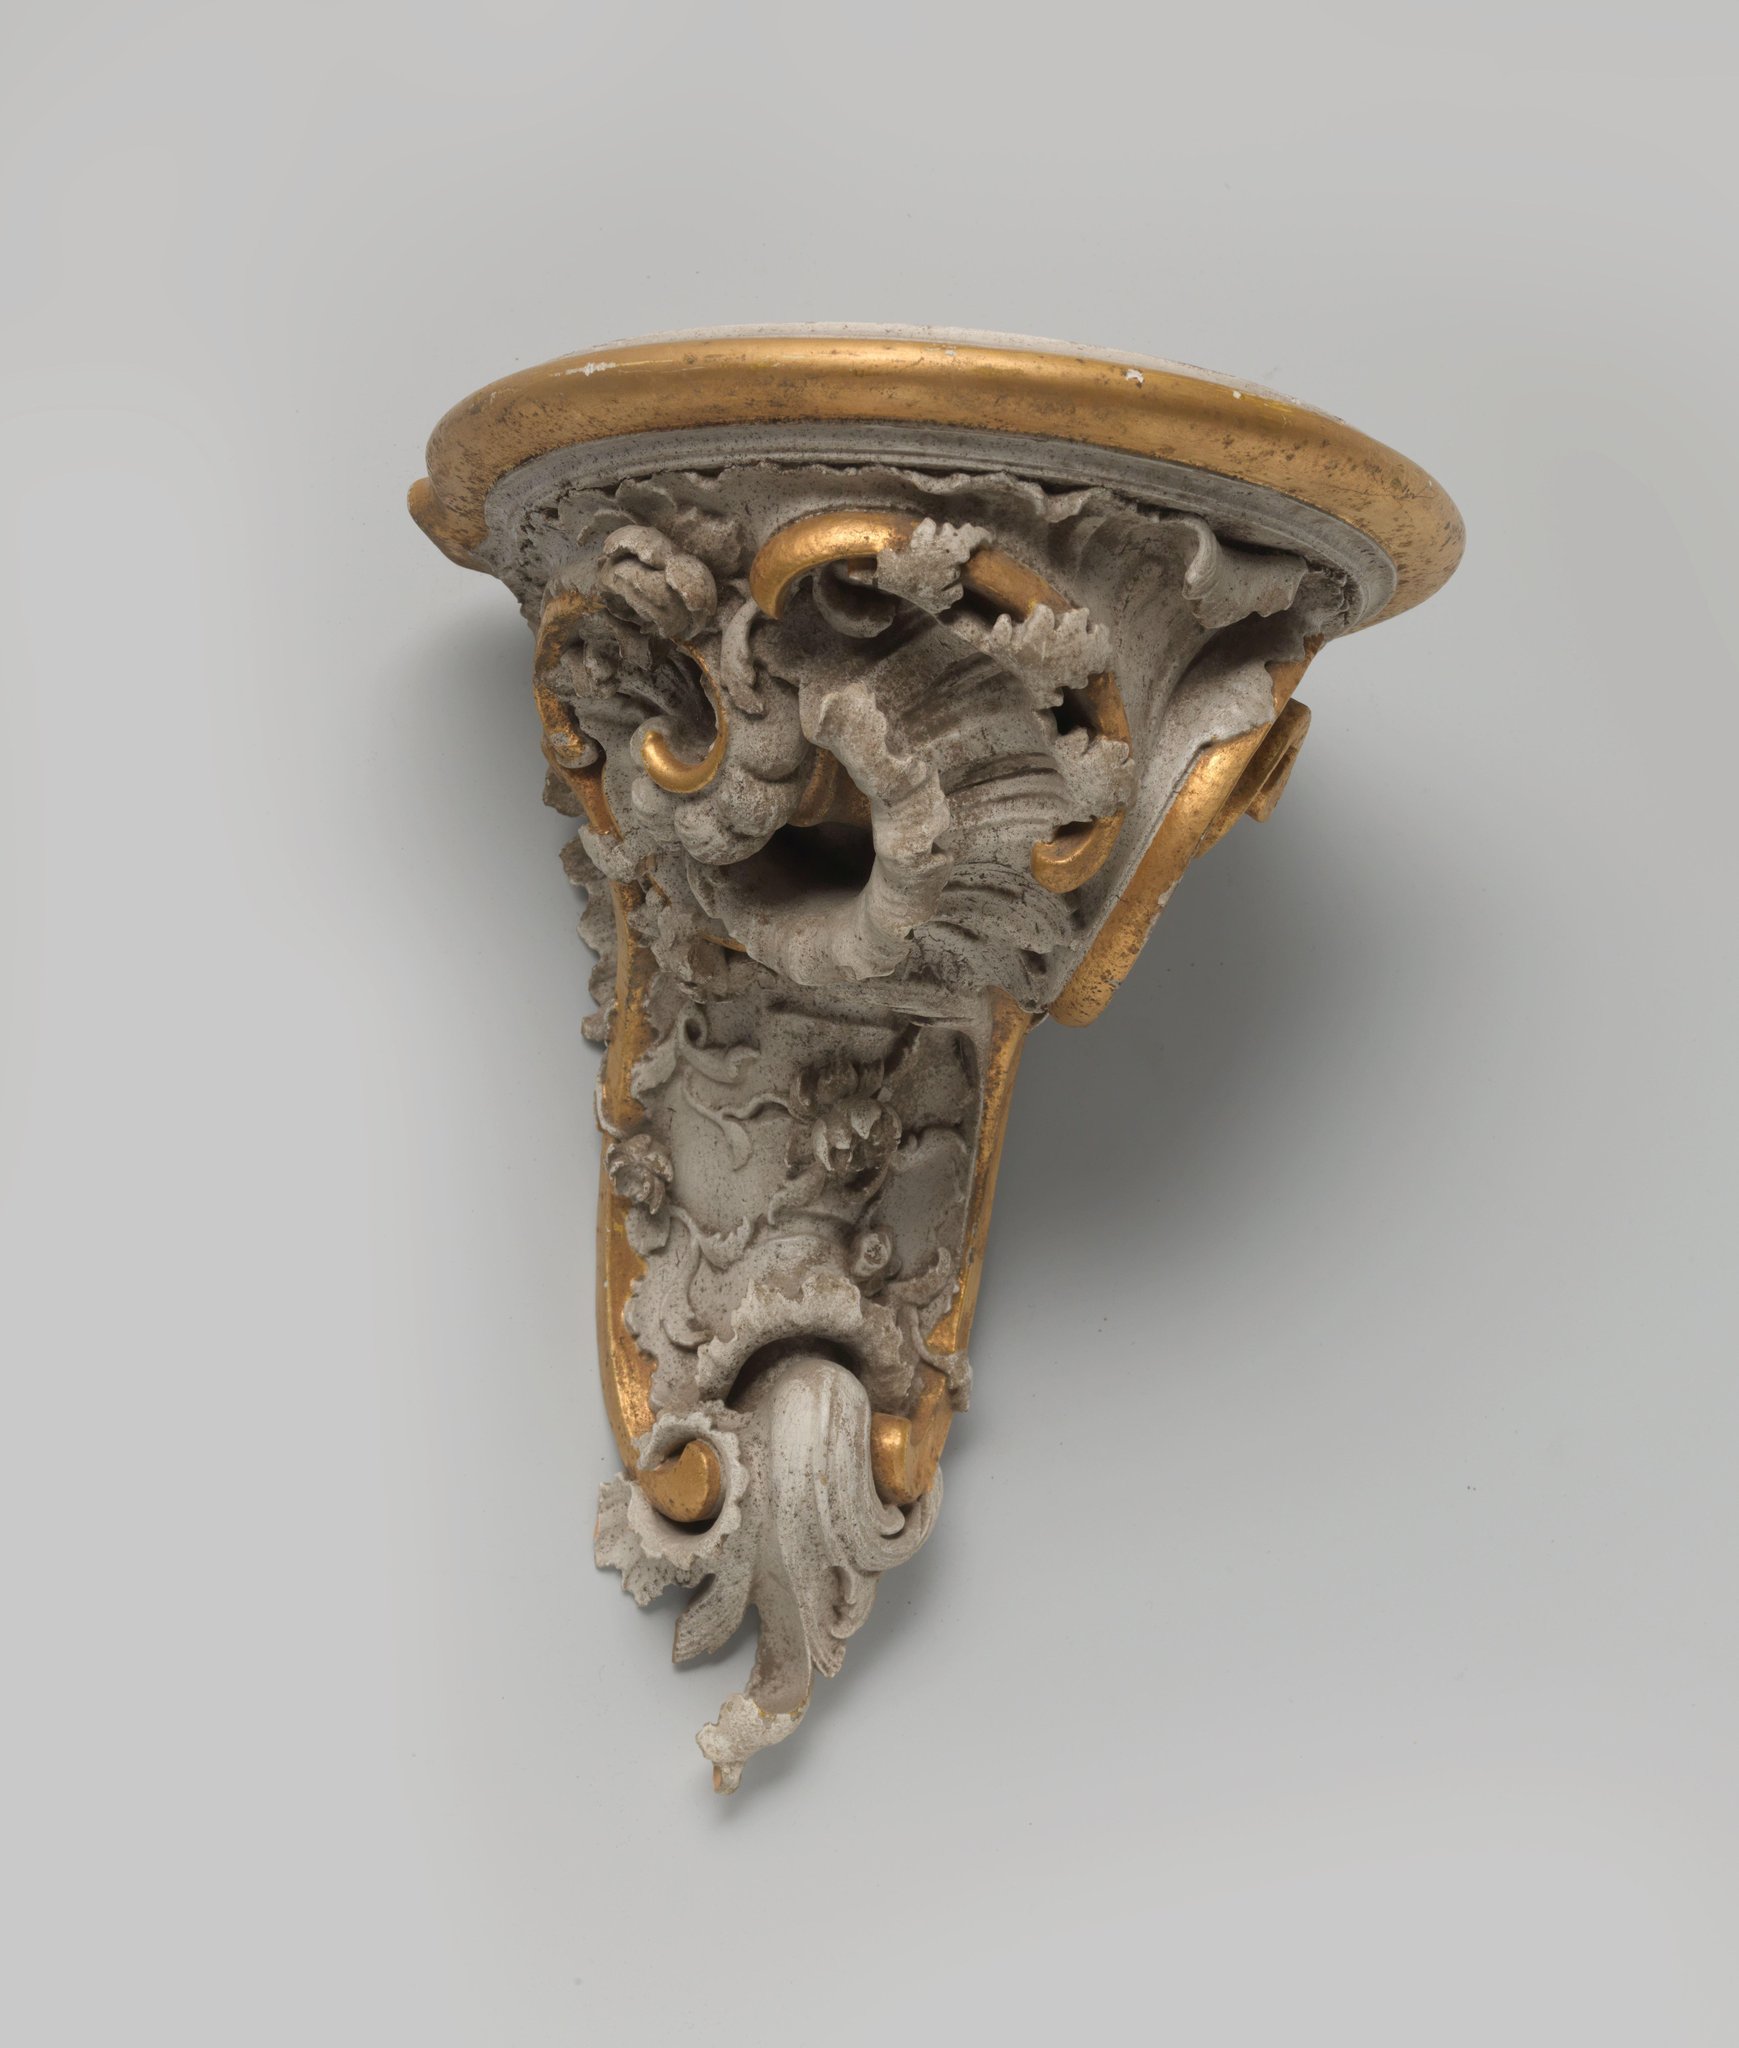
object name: fragment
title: Console van wit en goud beschilderd lindehout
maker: Anonymous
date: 1740-1760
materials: wood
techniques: gilding, painted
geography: northern netherlands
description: Console van wit en goud beschilderd lindehout, meubelfragment. De dekplaat wordt omsloten door een halfronde lijst, gevat tussen twee profiellijsten. Links rust deze plaat op een gebroken C-voluut, waaromheen acanthusblad; rechts op een gestrekte S- en C-voluut, omgeven door rozentakken. De verbinding tussen de genoemde voluten wordt gevormd door een omslaande kuifschelp, omgeven met rozentakken. De console eindigt in asymmetrische acanthusbladeren. Deze console is wellicht afkomstig van een buffetkast.